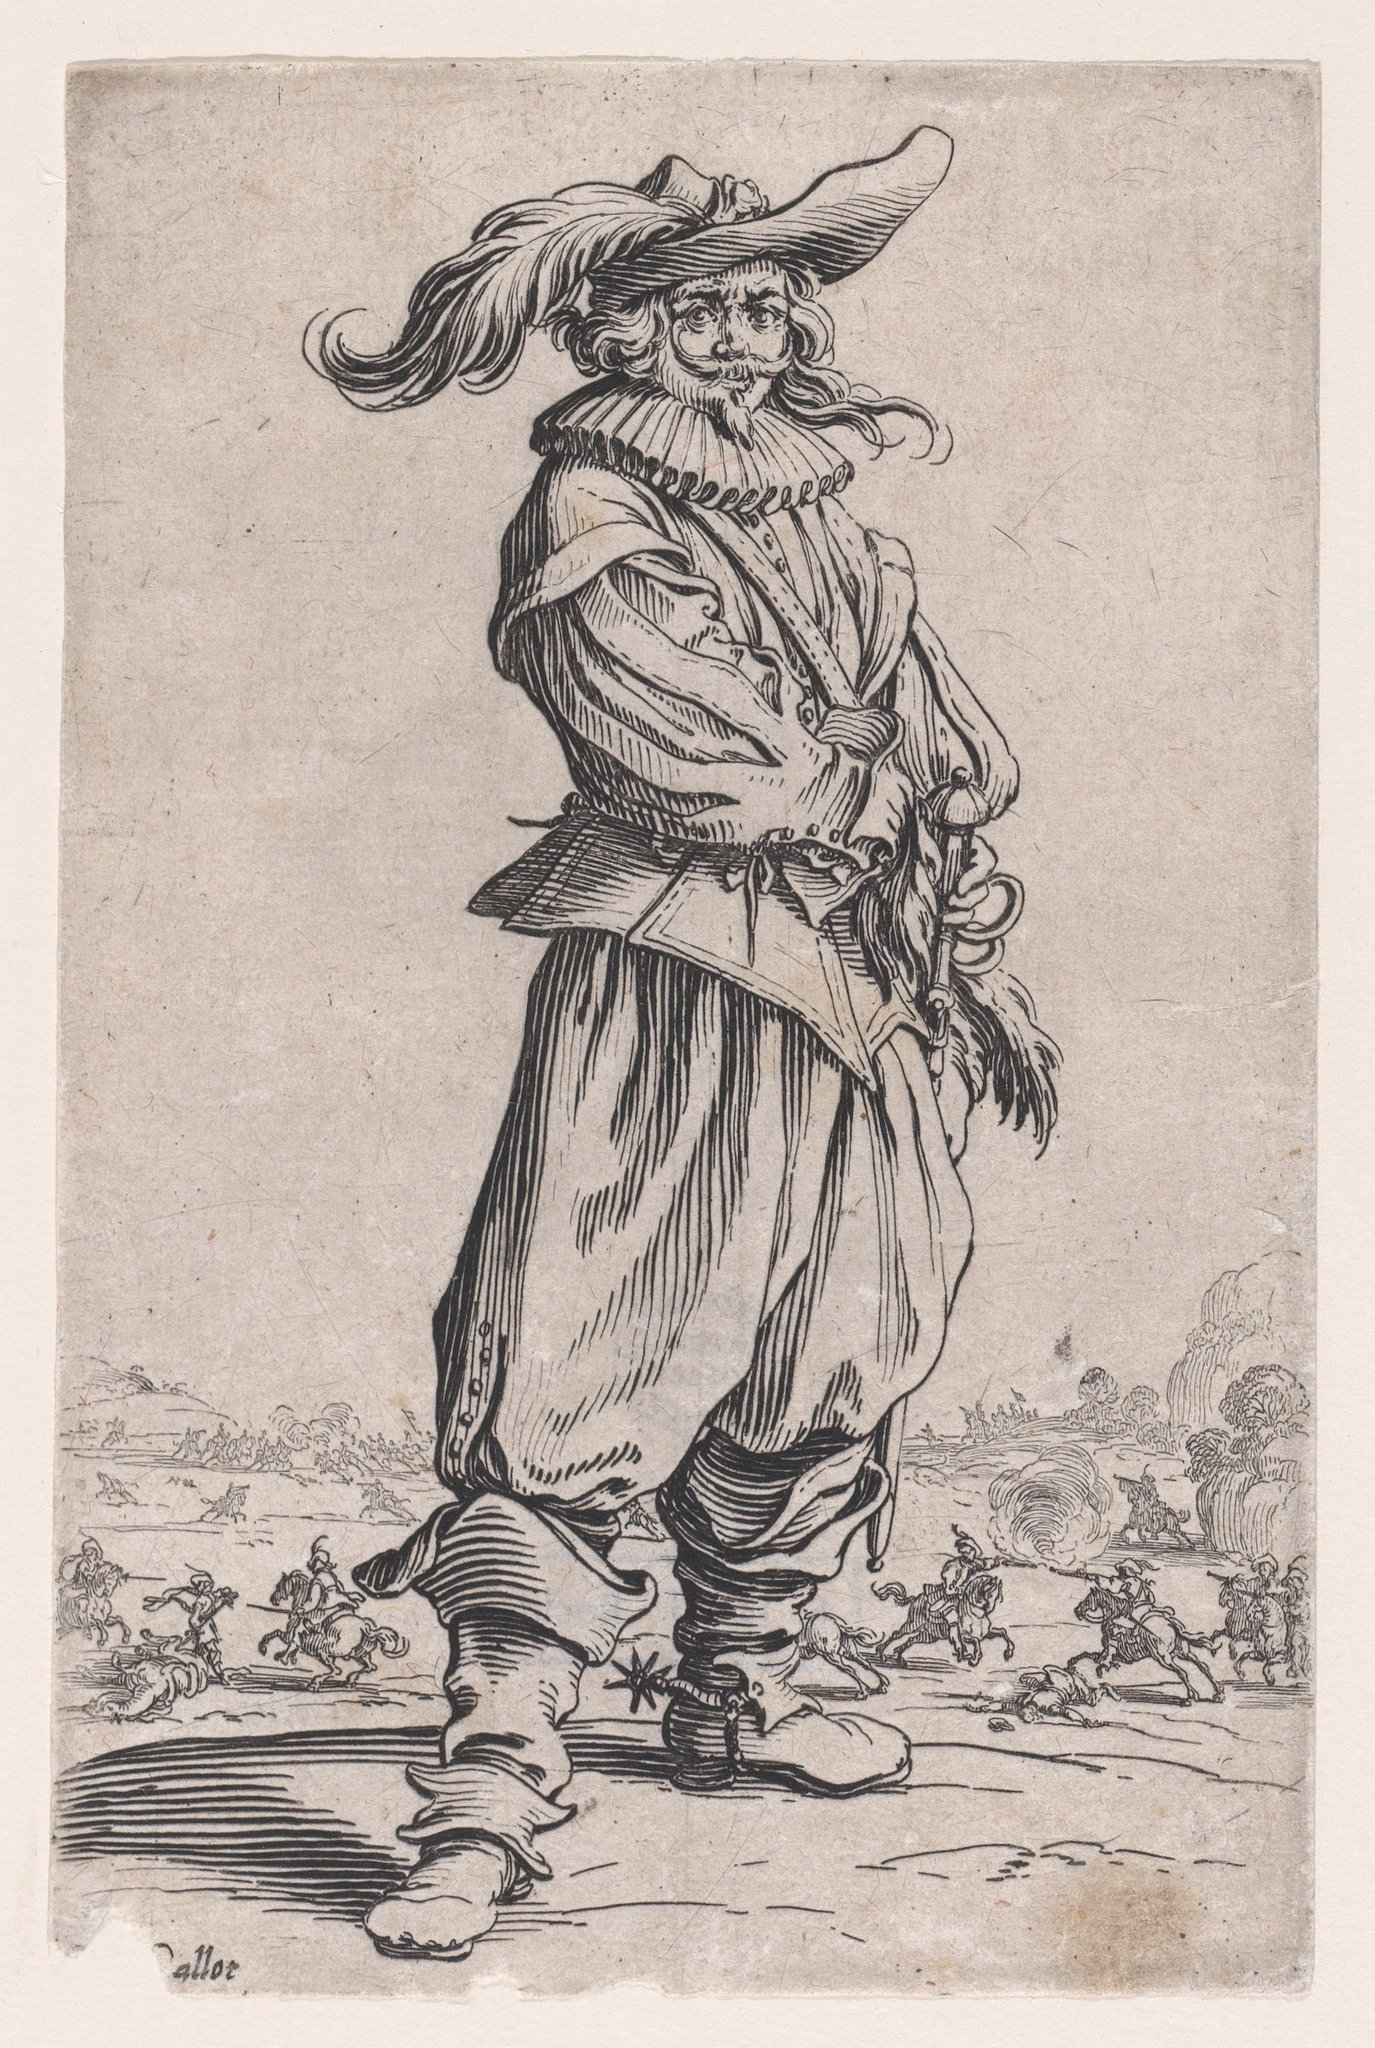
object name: print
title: Le Guerrier au Chapeau Orné d'une Grande Plume (The Officer with a Large Feather in His Hat), from "La Noblesse" (The Nobility)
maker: jacques callot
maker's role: artist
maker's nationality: french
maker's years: 1592-1635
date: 1623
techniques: etching